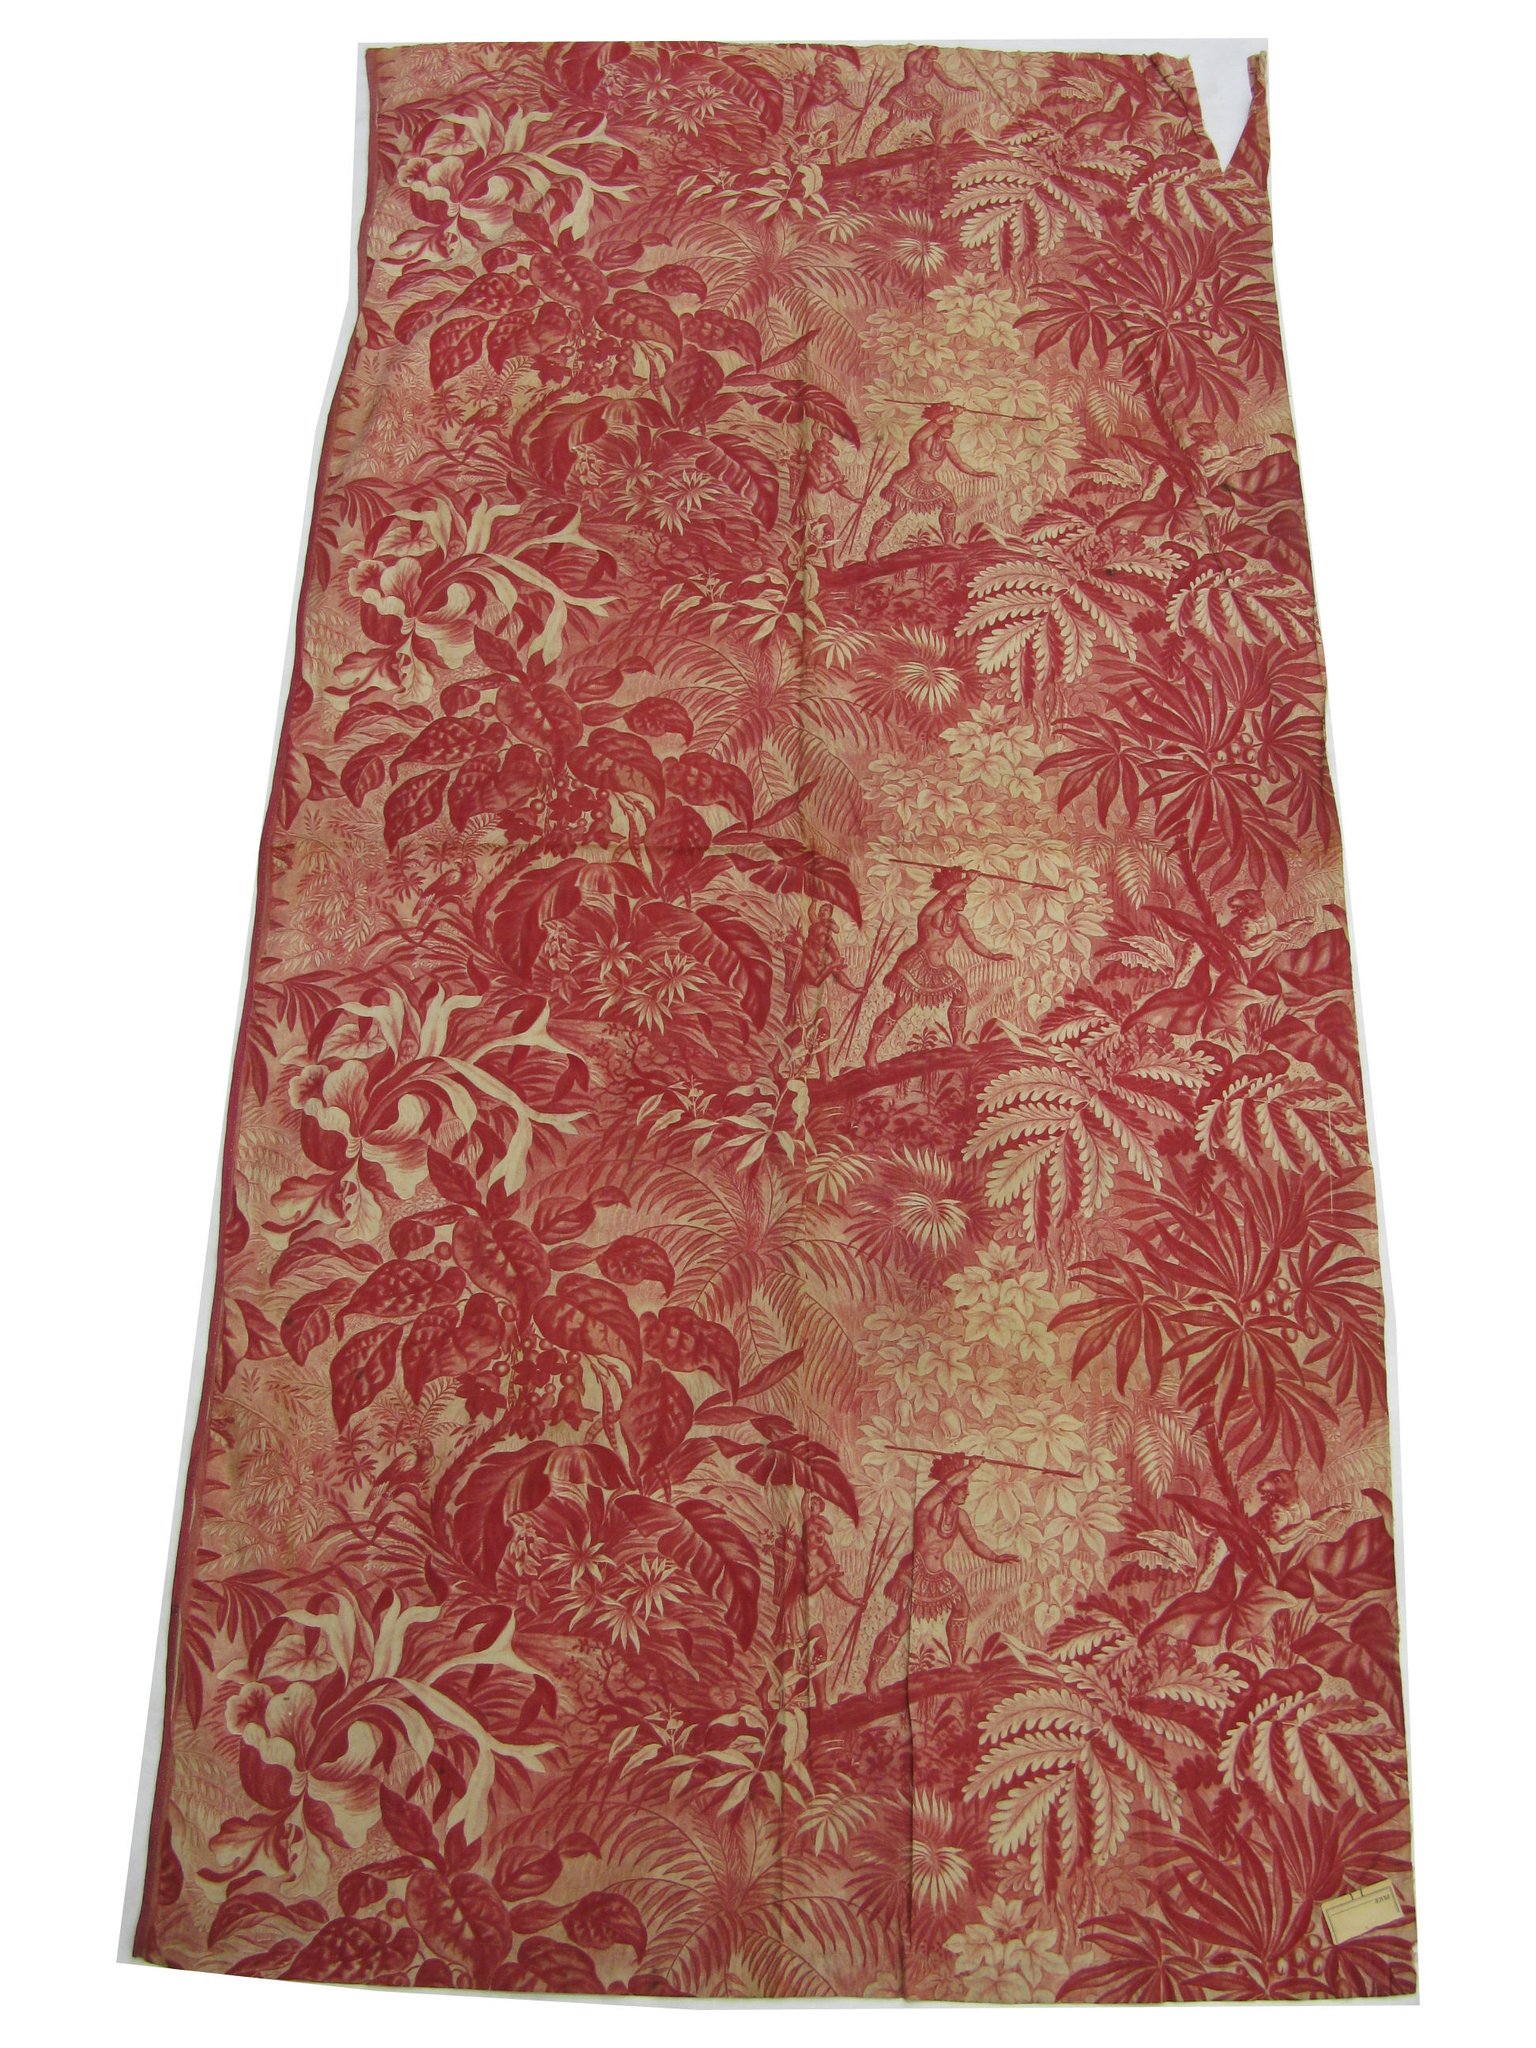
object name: length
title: Jungle scene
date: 1826-1850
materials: cotton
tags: birds,men,hunting,forests